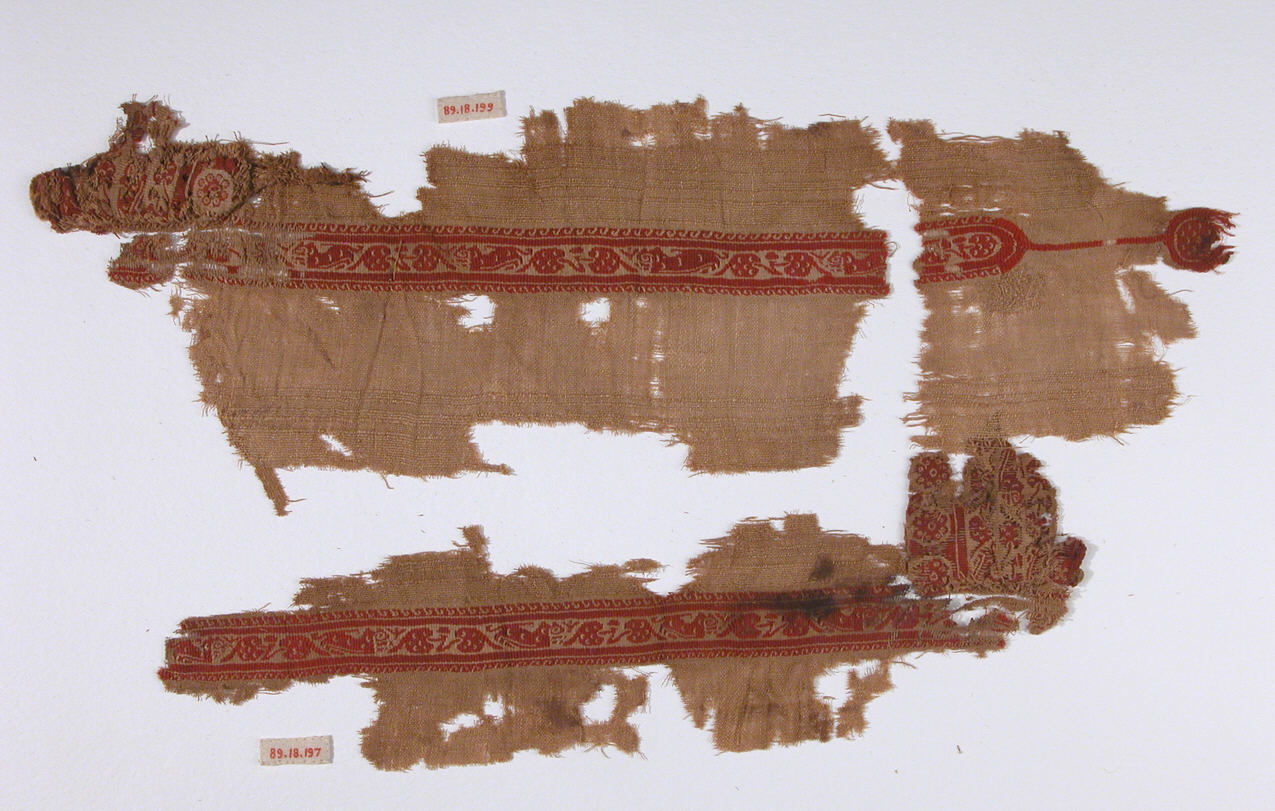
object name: textile fragment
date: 201-400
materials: linen, wool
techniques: weave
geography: egypt